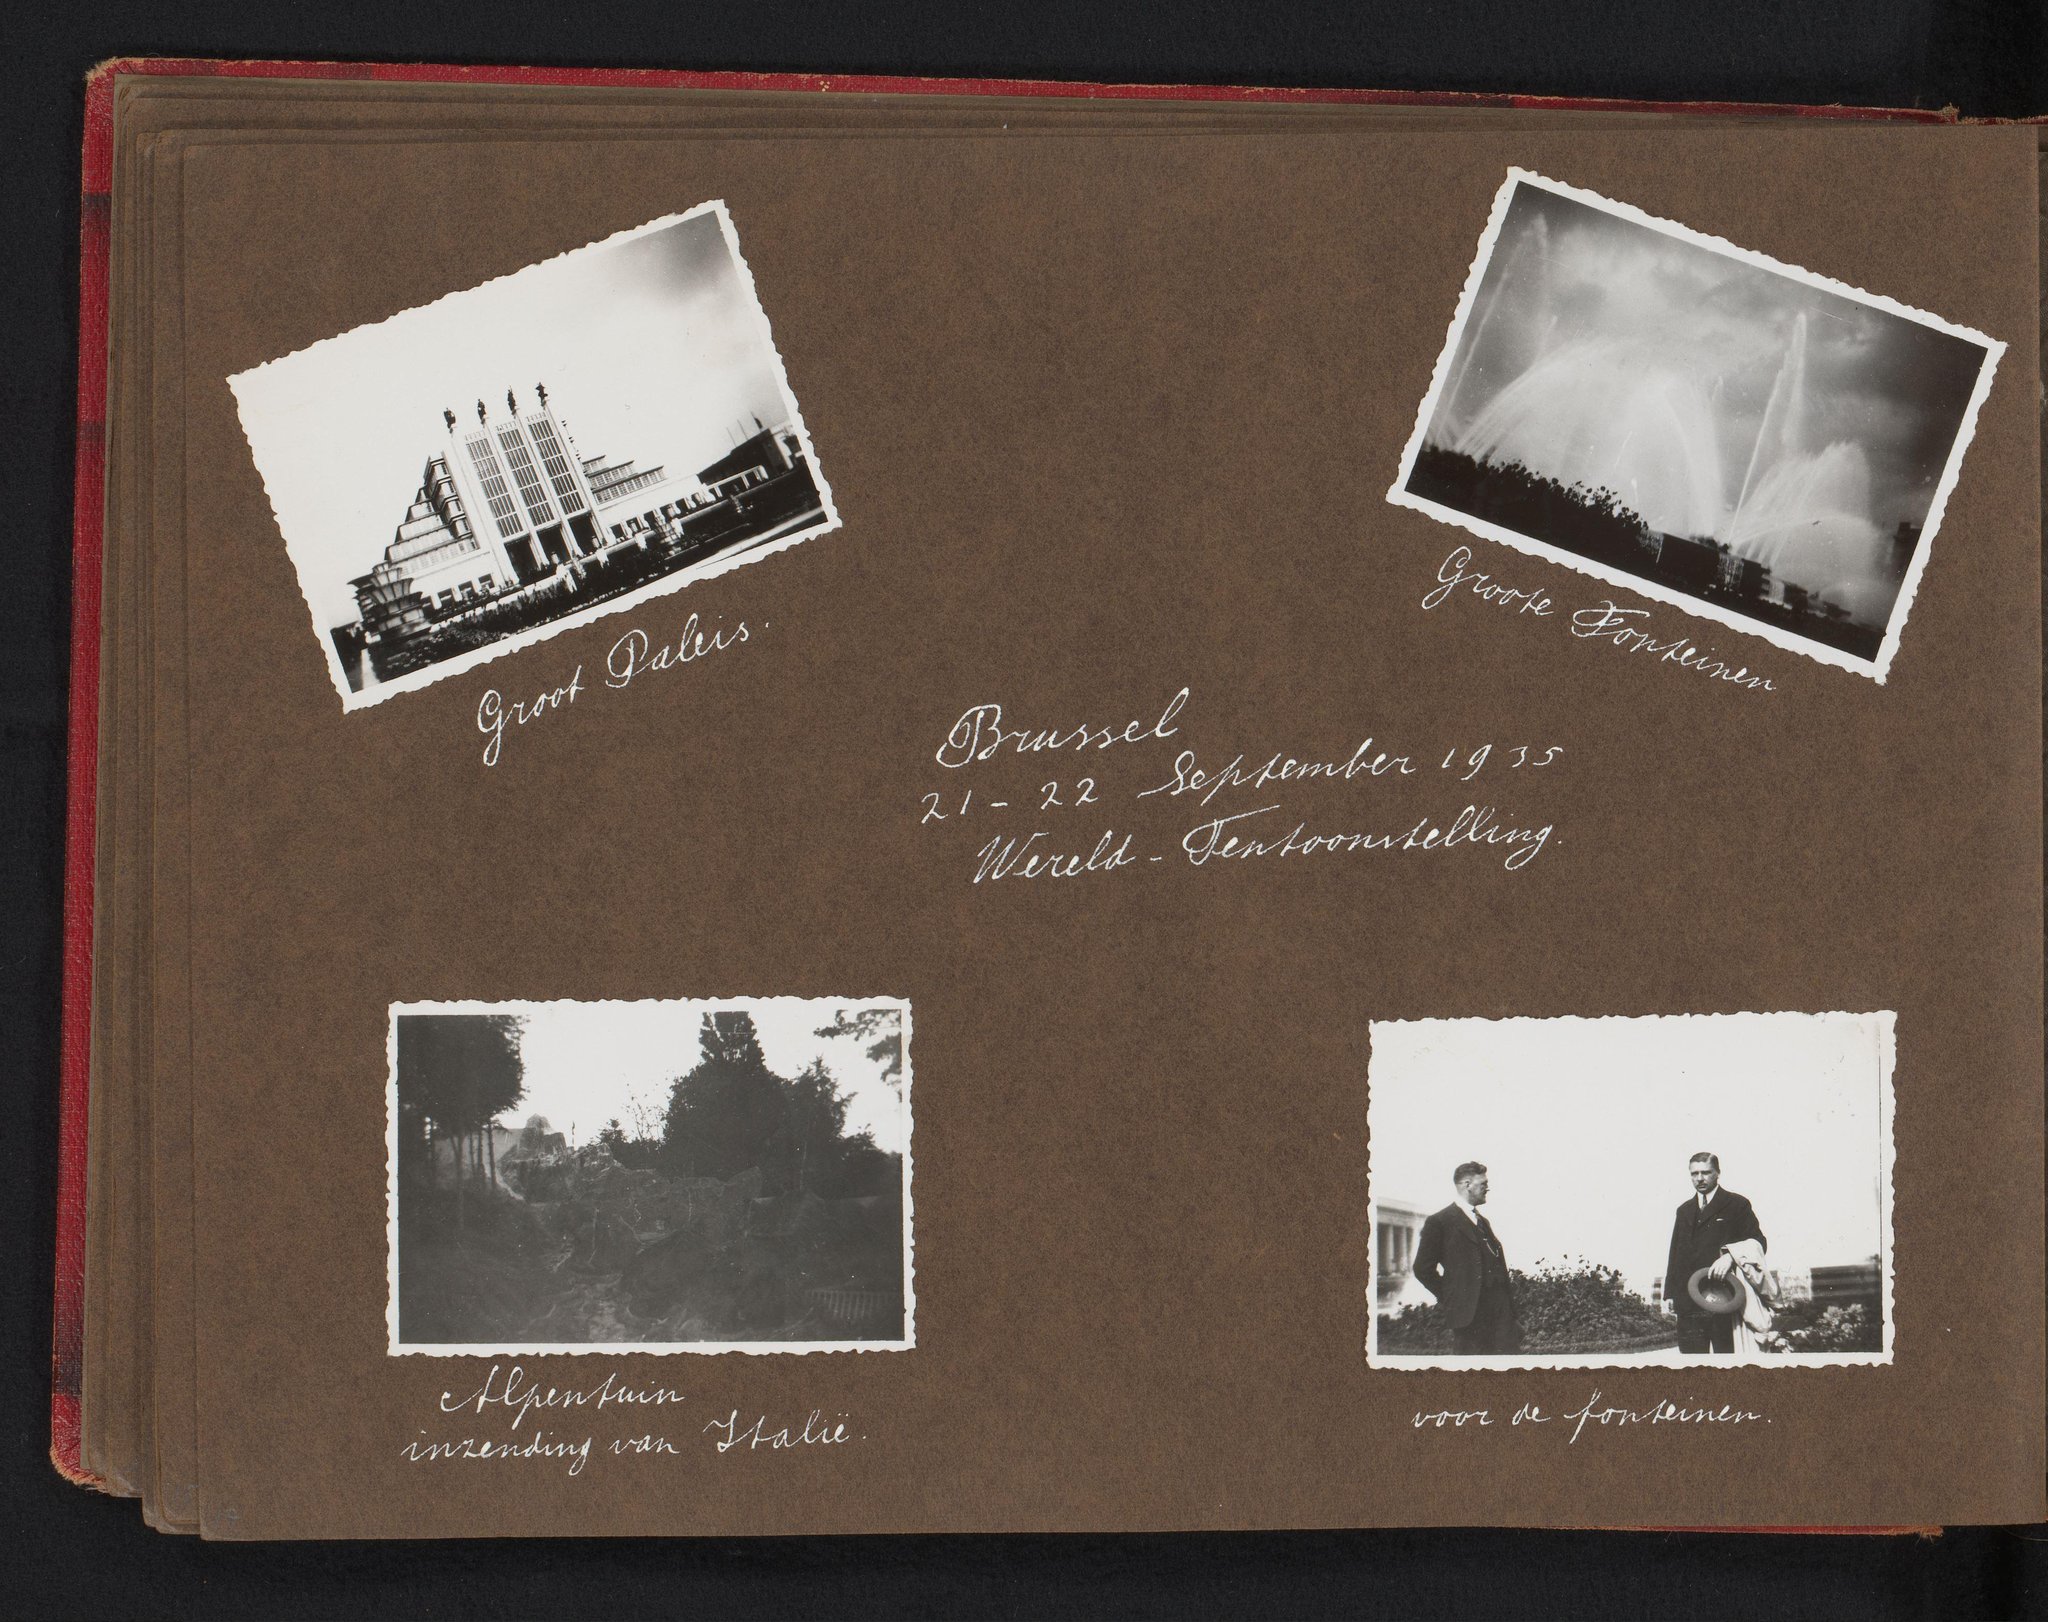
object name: photograph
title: Brussel 21-22 September 1935 Wereld-Tentoonstelling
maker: Anonymous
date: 1909-1935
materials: paper, photographic support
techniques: gelatin silver print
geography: brussels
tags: world fair, world exhibition, outing, pleasure trip, brussels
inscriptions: inscription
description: Albumblad met vier foto's van het bezoek aan de wereldtentoonstelling in Brussel, 21-22 september 1935. Onderdeel van het reisalbum van de familie Van den Broek 1935-1937.